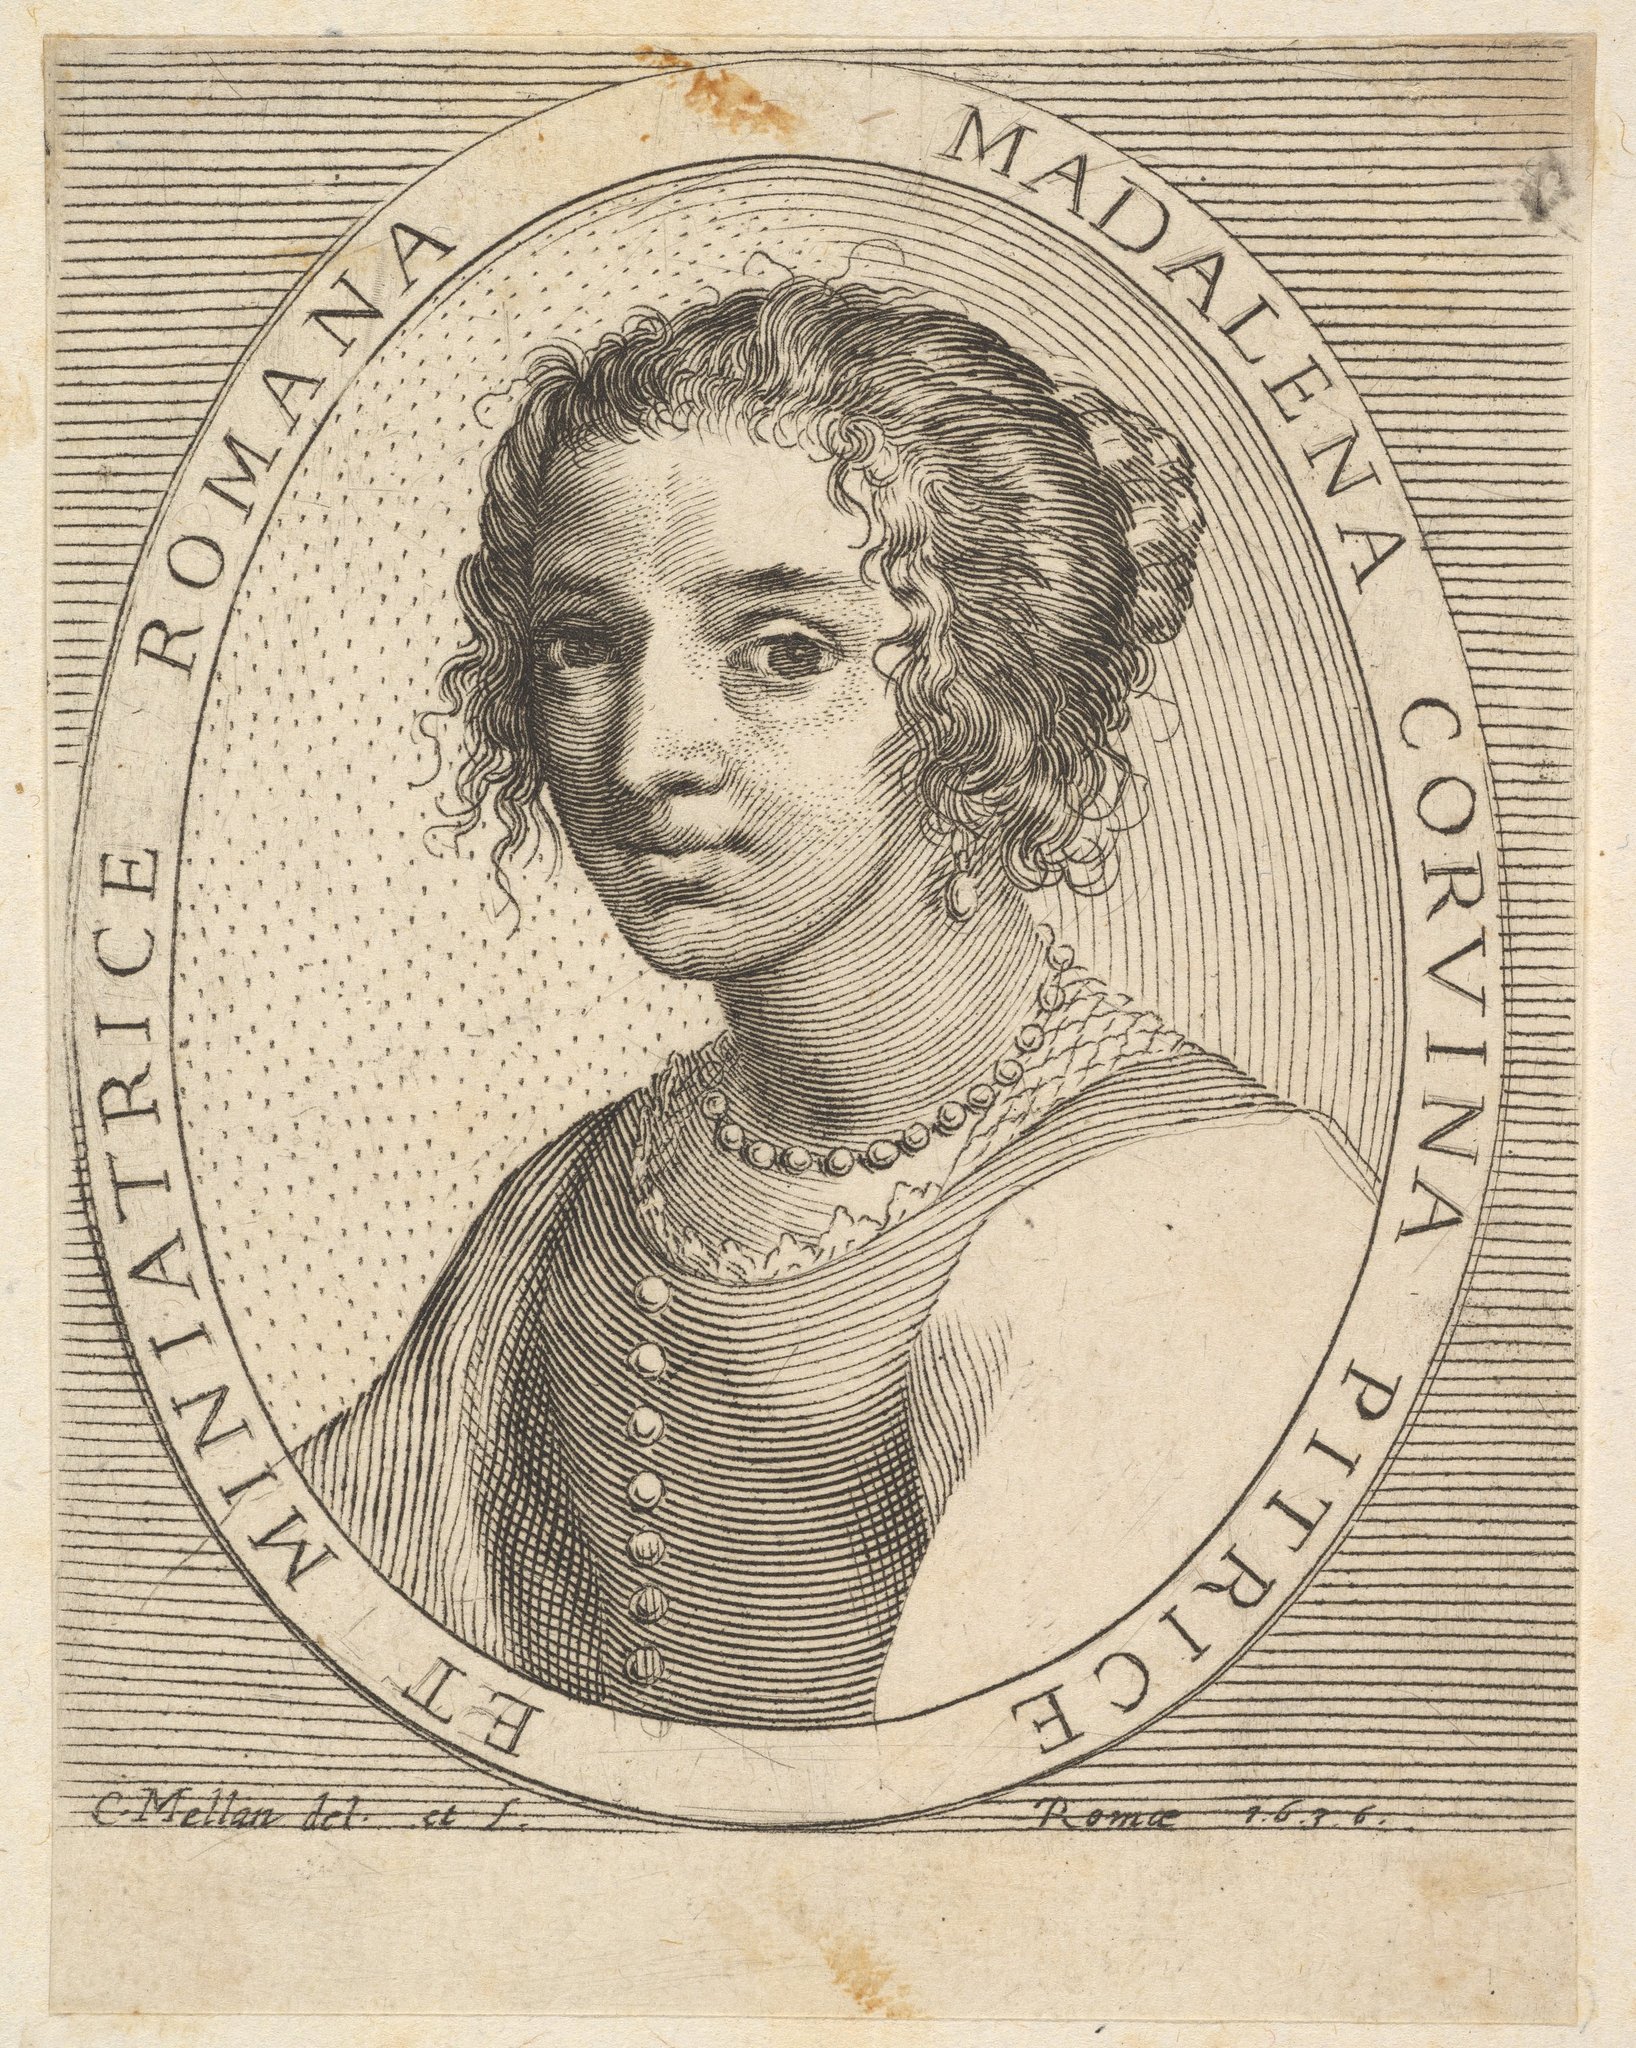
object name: print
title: Maddalena Corvina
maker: claude mellan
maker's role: artist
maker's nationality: french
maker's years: 1598-1688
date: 1636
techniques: engraving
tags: portraits,women